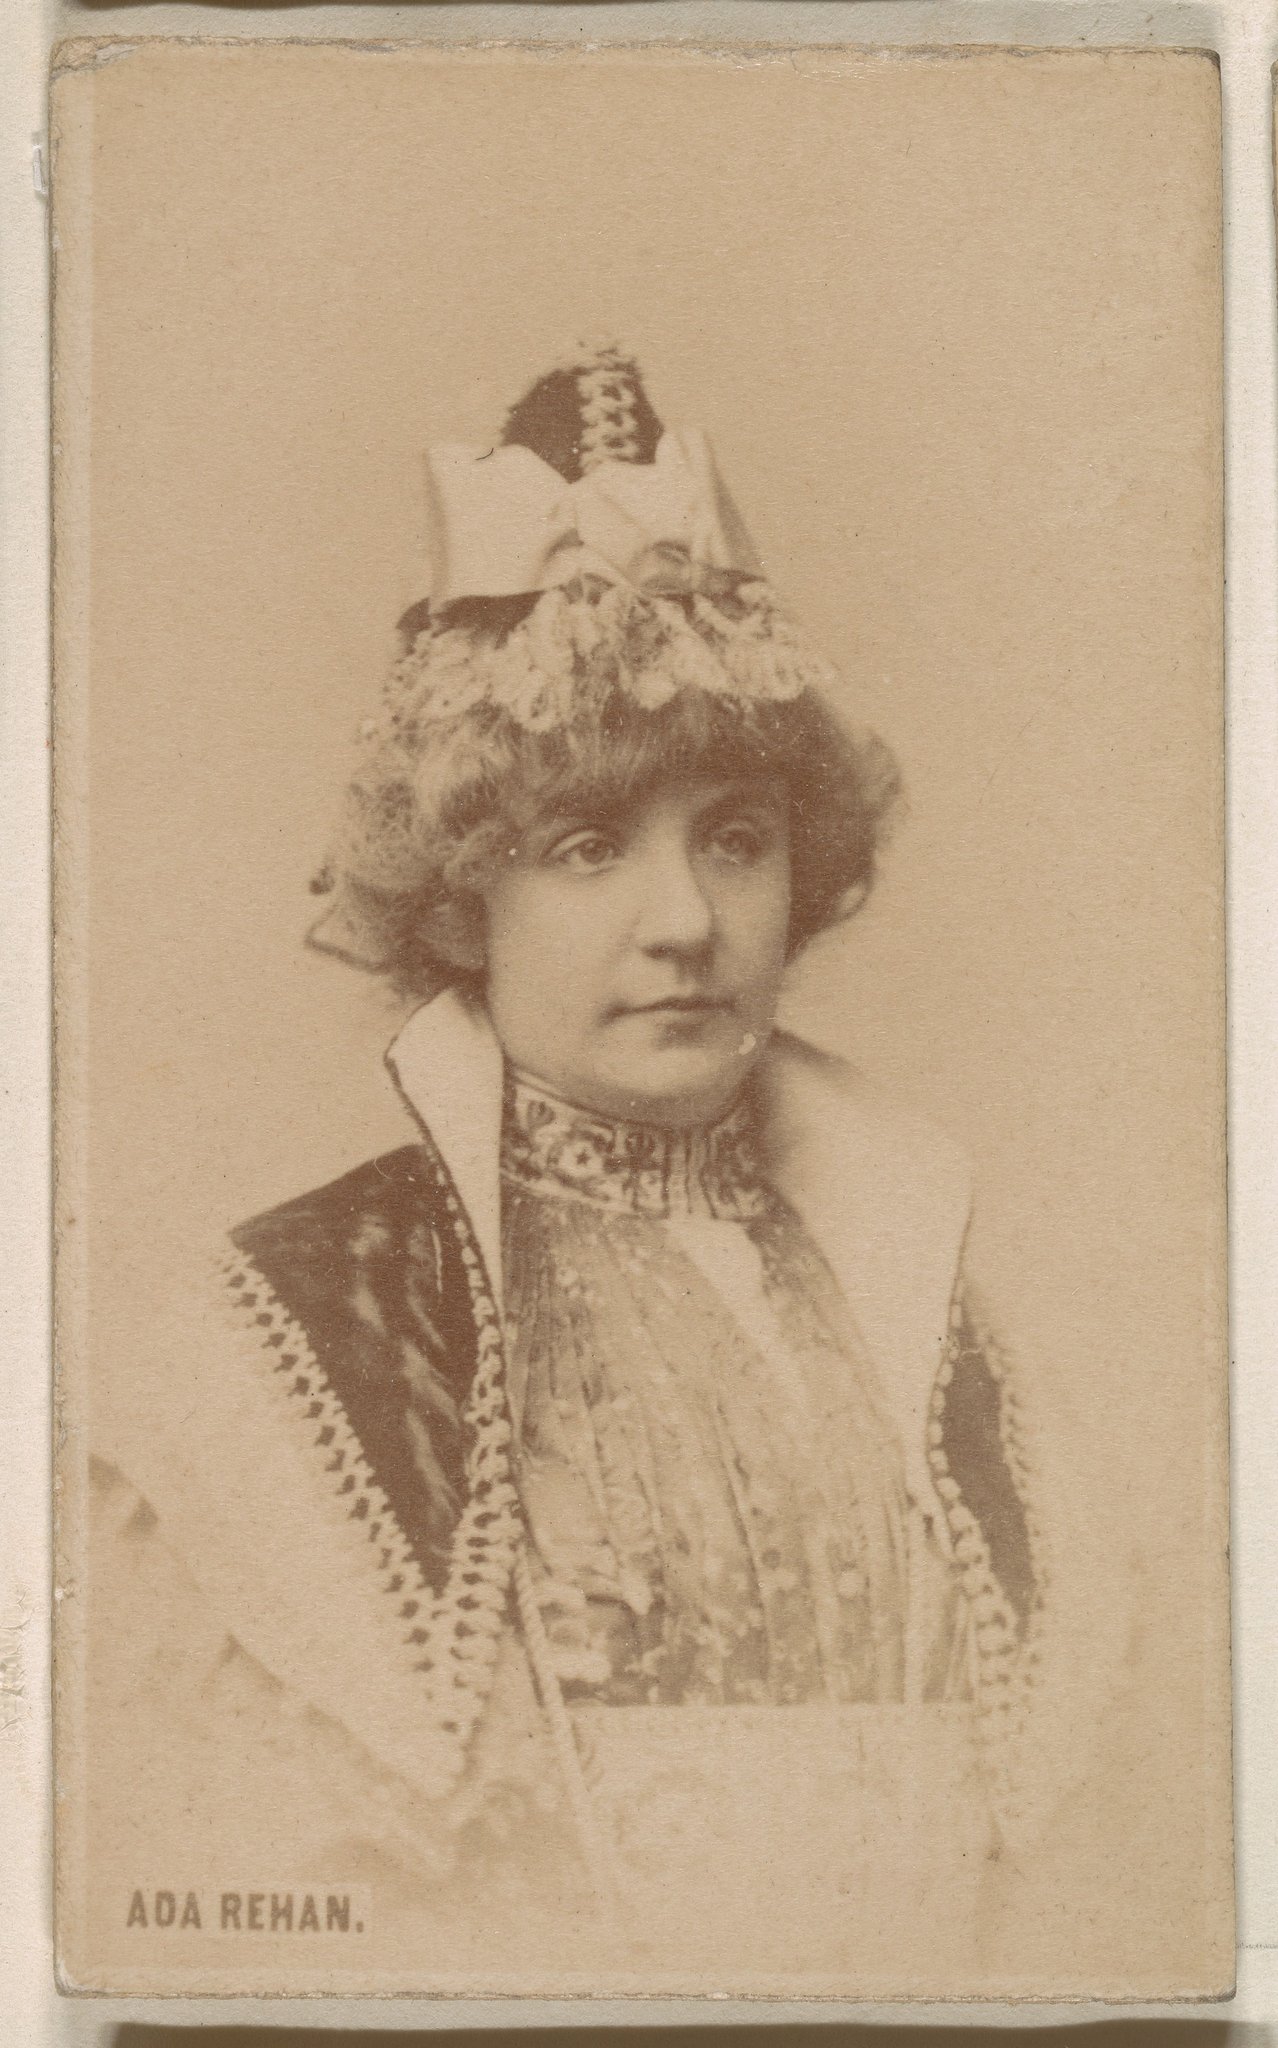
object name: photograph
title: Ada Rehan, from the Actresses series (N246), Type 1, issued by Kinney Brothers to promote Sporting Extra Cigarettes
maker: kinney brothers tobacco company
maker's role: publisher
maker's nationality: american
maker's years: 1869-2011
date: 1890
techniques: albumen silver print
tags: portraits,women,actresses